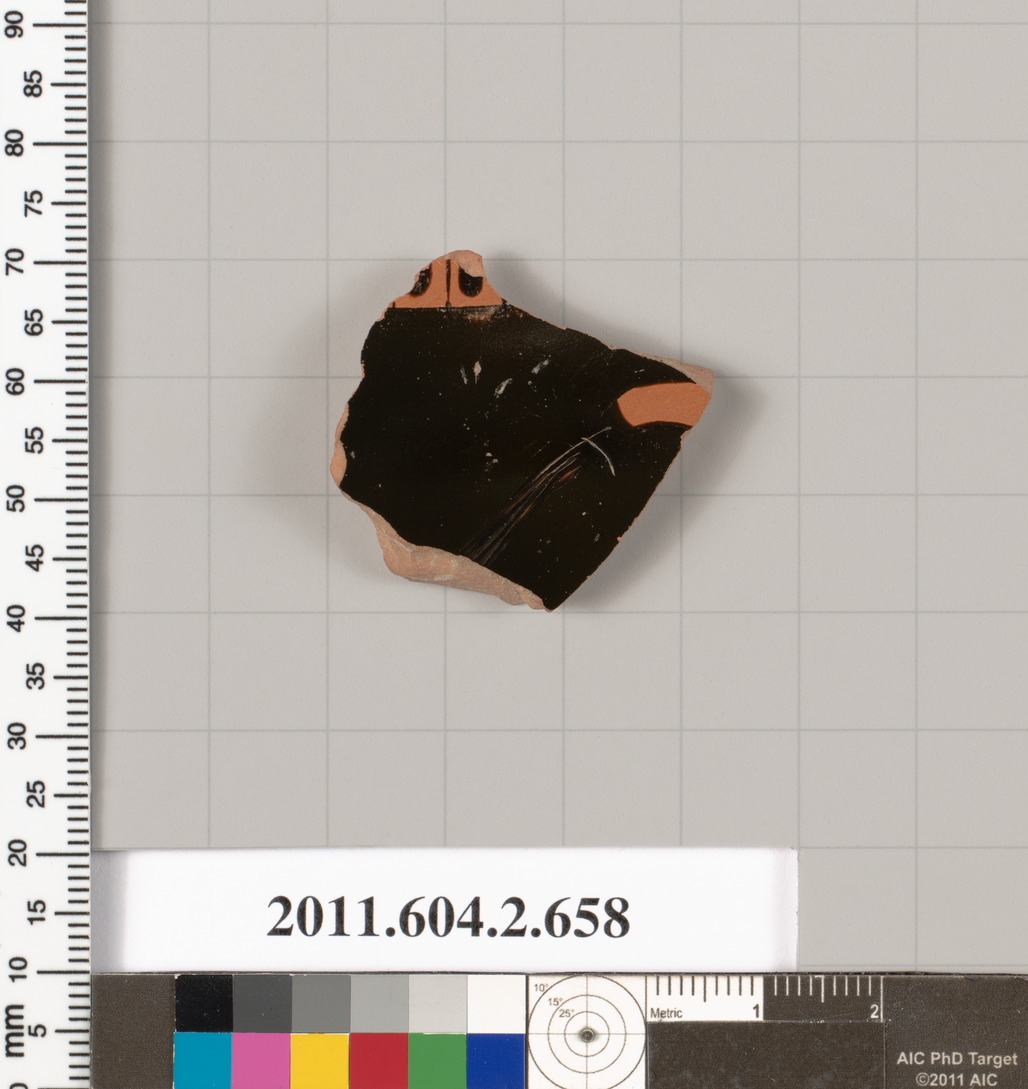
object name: column krater fragment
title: Terracotta fragment of a column-krater (bowl for mixing wine and water)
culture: greek, attic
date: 460-450 BCE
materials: terracotta